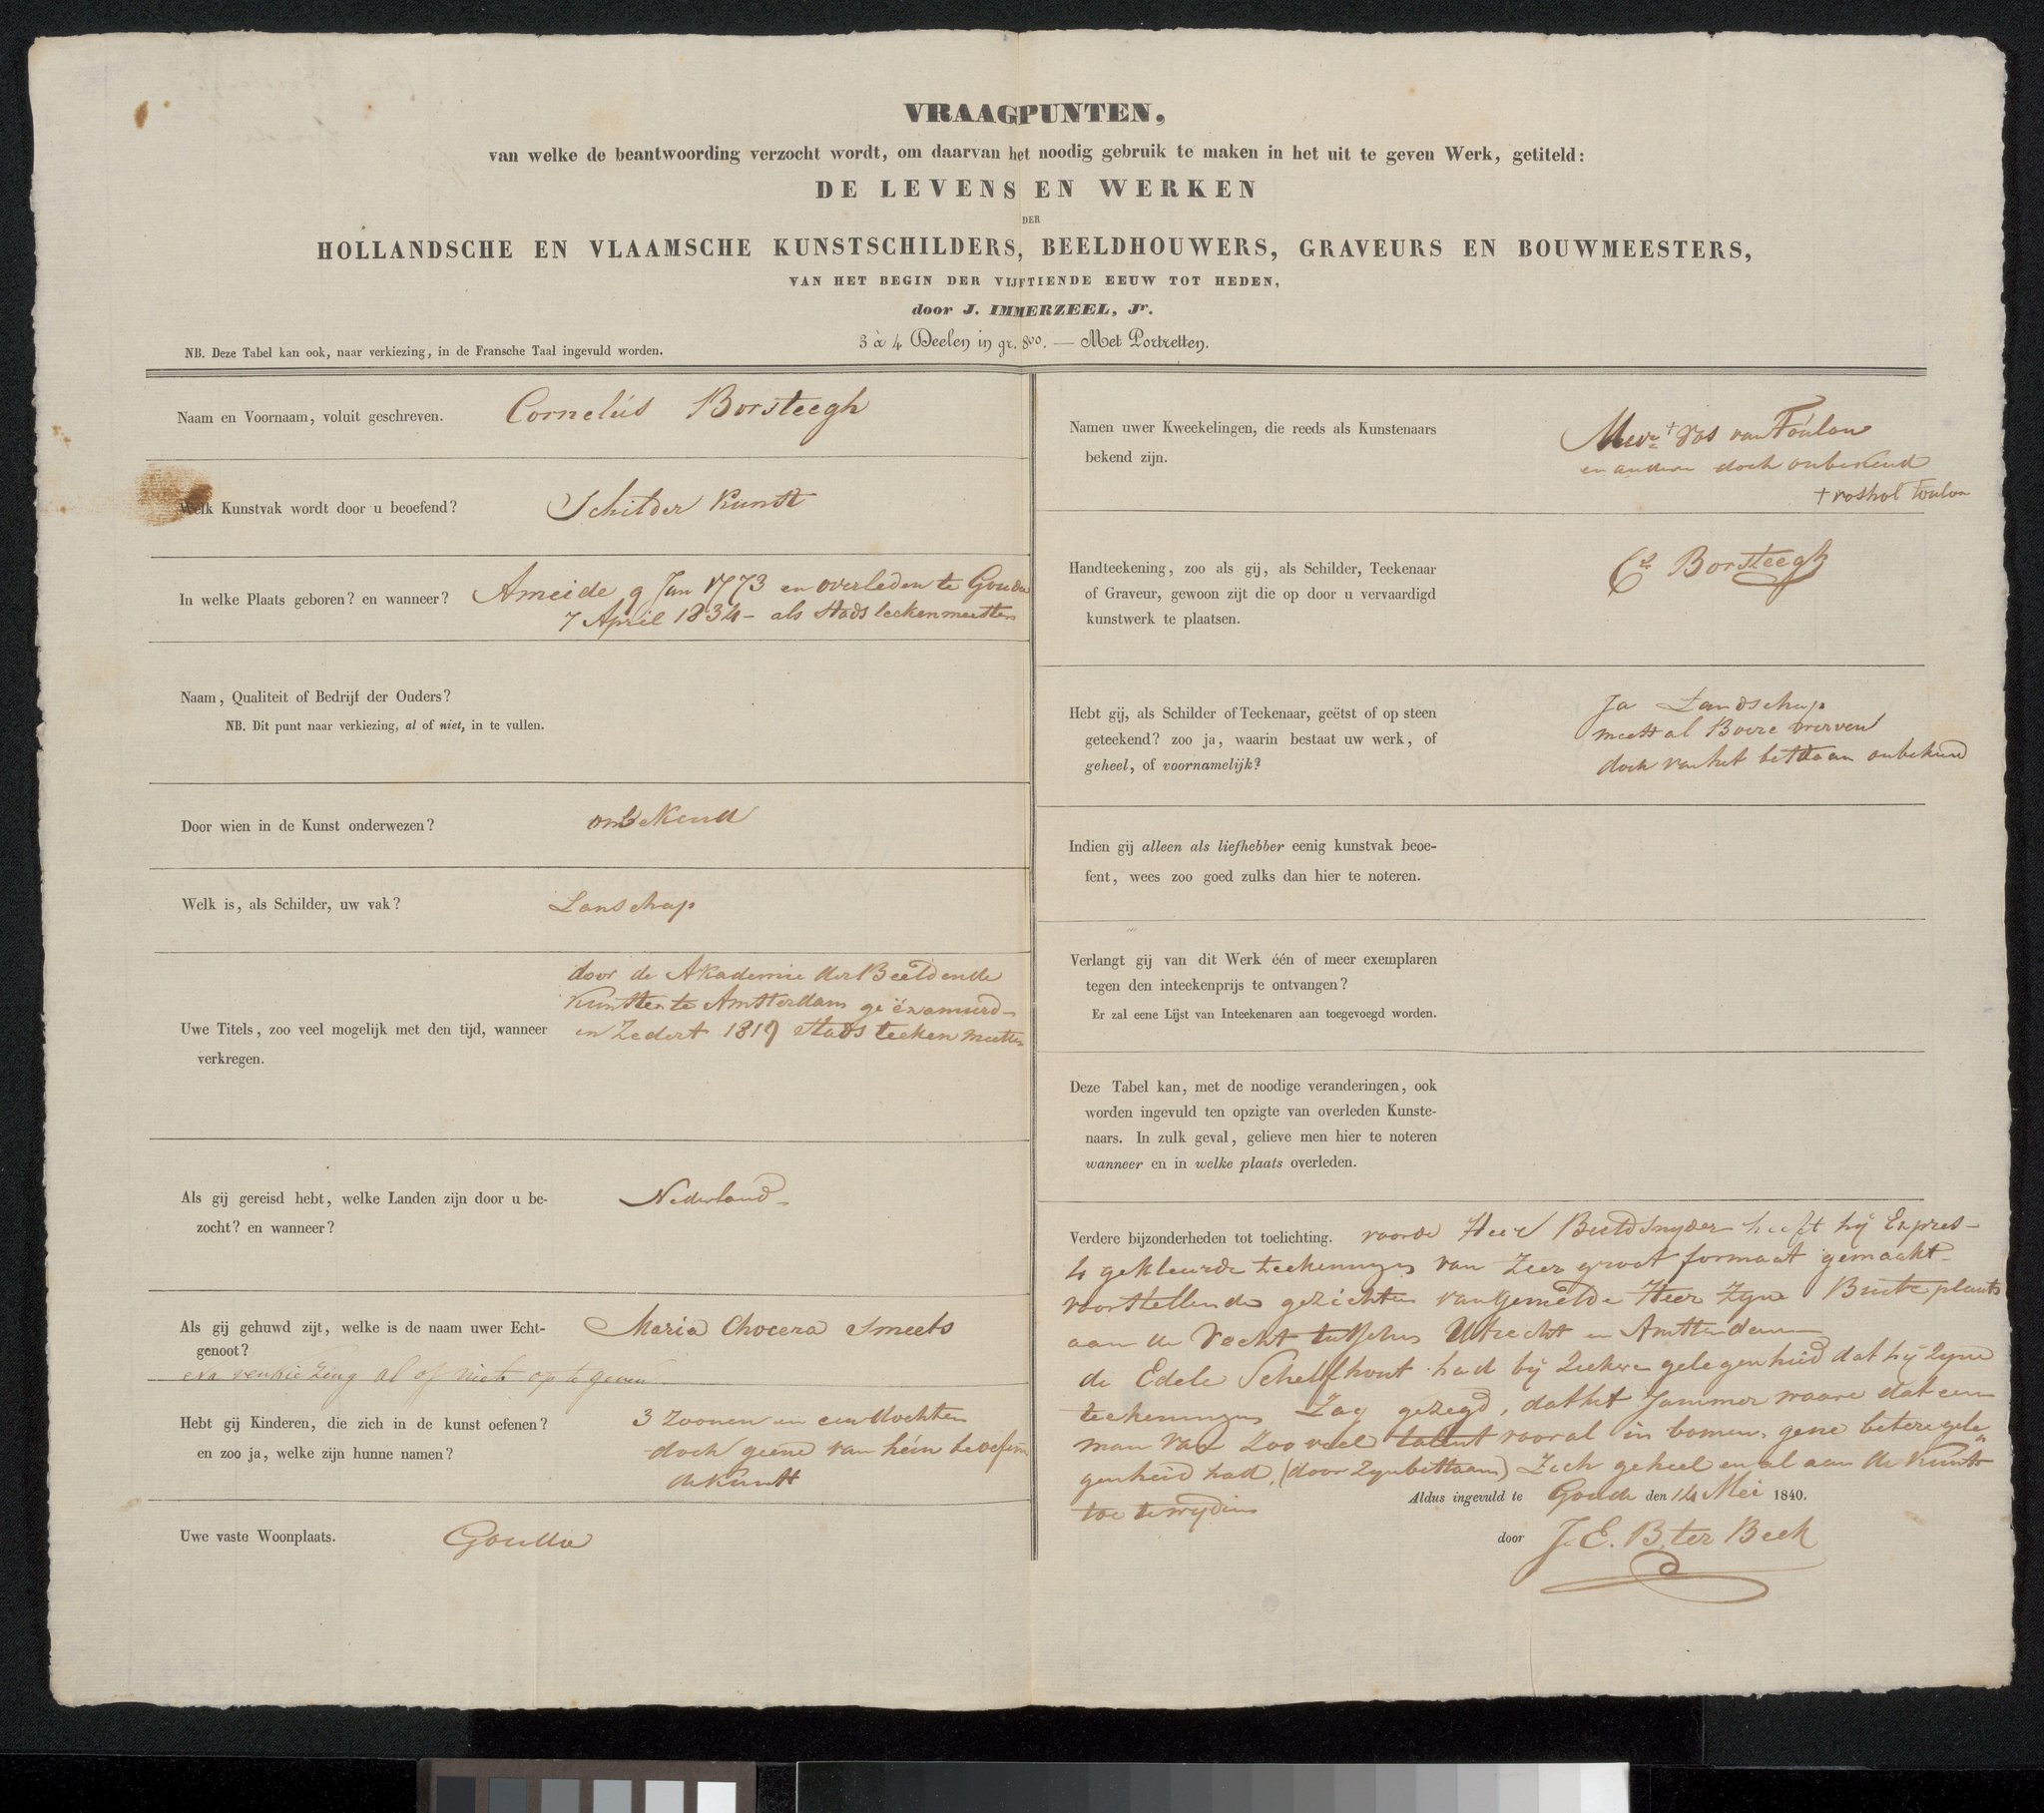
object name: manuscript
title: Enquêteformulier betreffende Cornelis Borsteegh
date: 1840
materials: ink, paper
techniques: pen, printing, writing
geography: gouda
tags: cornelis borsteegh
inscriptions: watermark, inscription: ‘Vraagpunten,/ van welke de beantwoording verzocht wordt, om daarvan het noodig gebruik te maken in het uit te geven Werk, getiteld: De levens en werken/ der Hollandsche en Vlaamsche kunstschilders, beeldhouwers,/ graveurs en bouwmeesters, van het begin der vijftiende eeuw tot heden/ door J. Immerzeel, Jr.’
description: Opgenomen in: Immerzeel, J. Jr., De levens en werken der Hollandsche en Vlaamsche kunstschilders, beeldhouwers, graveurs en bouwmeesters, van het begin der vijftiende eeuw tot heden, Amsterdam: J.C. van Kesteren, 1842-1843.